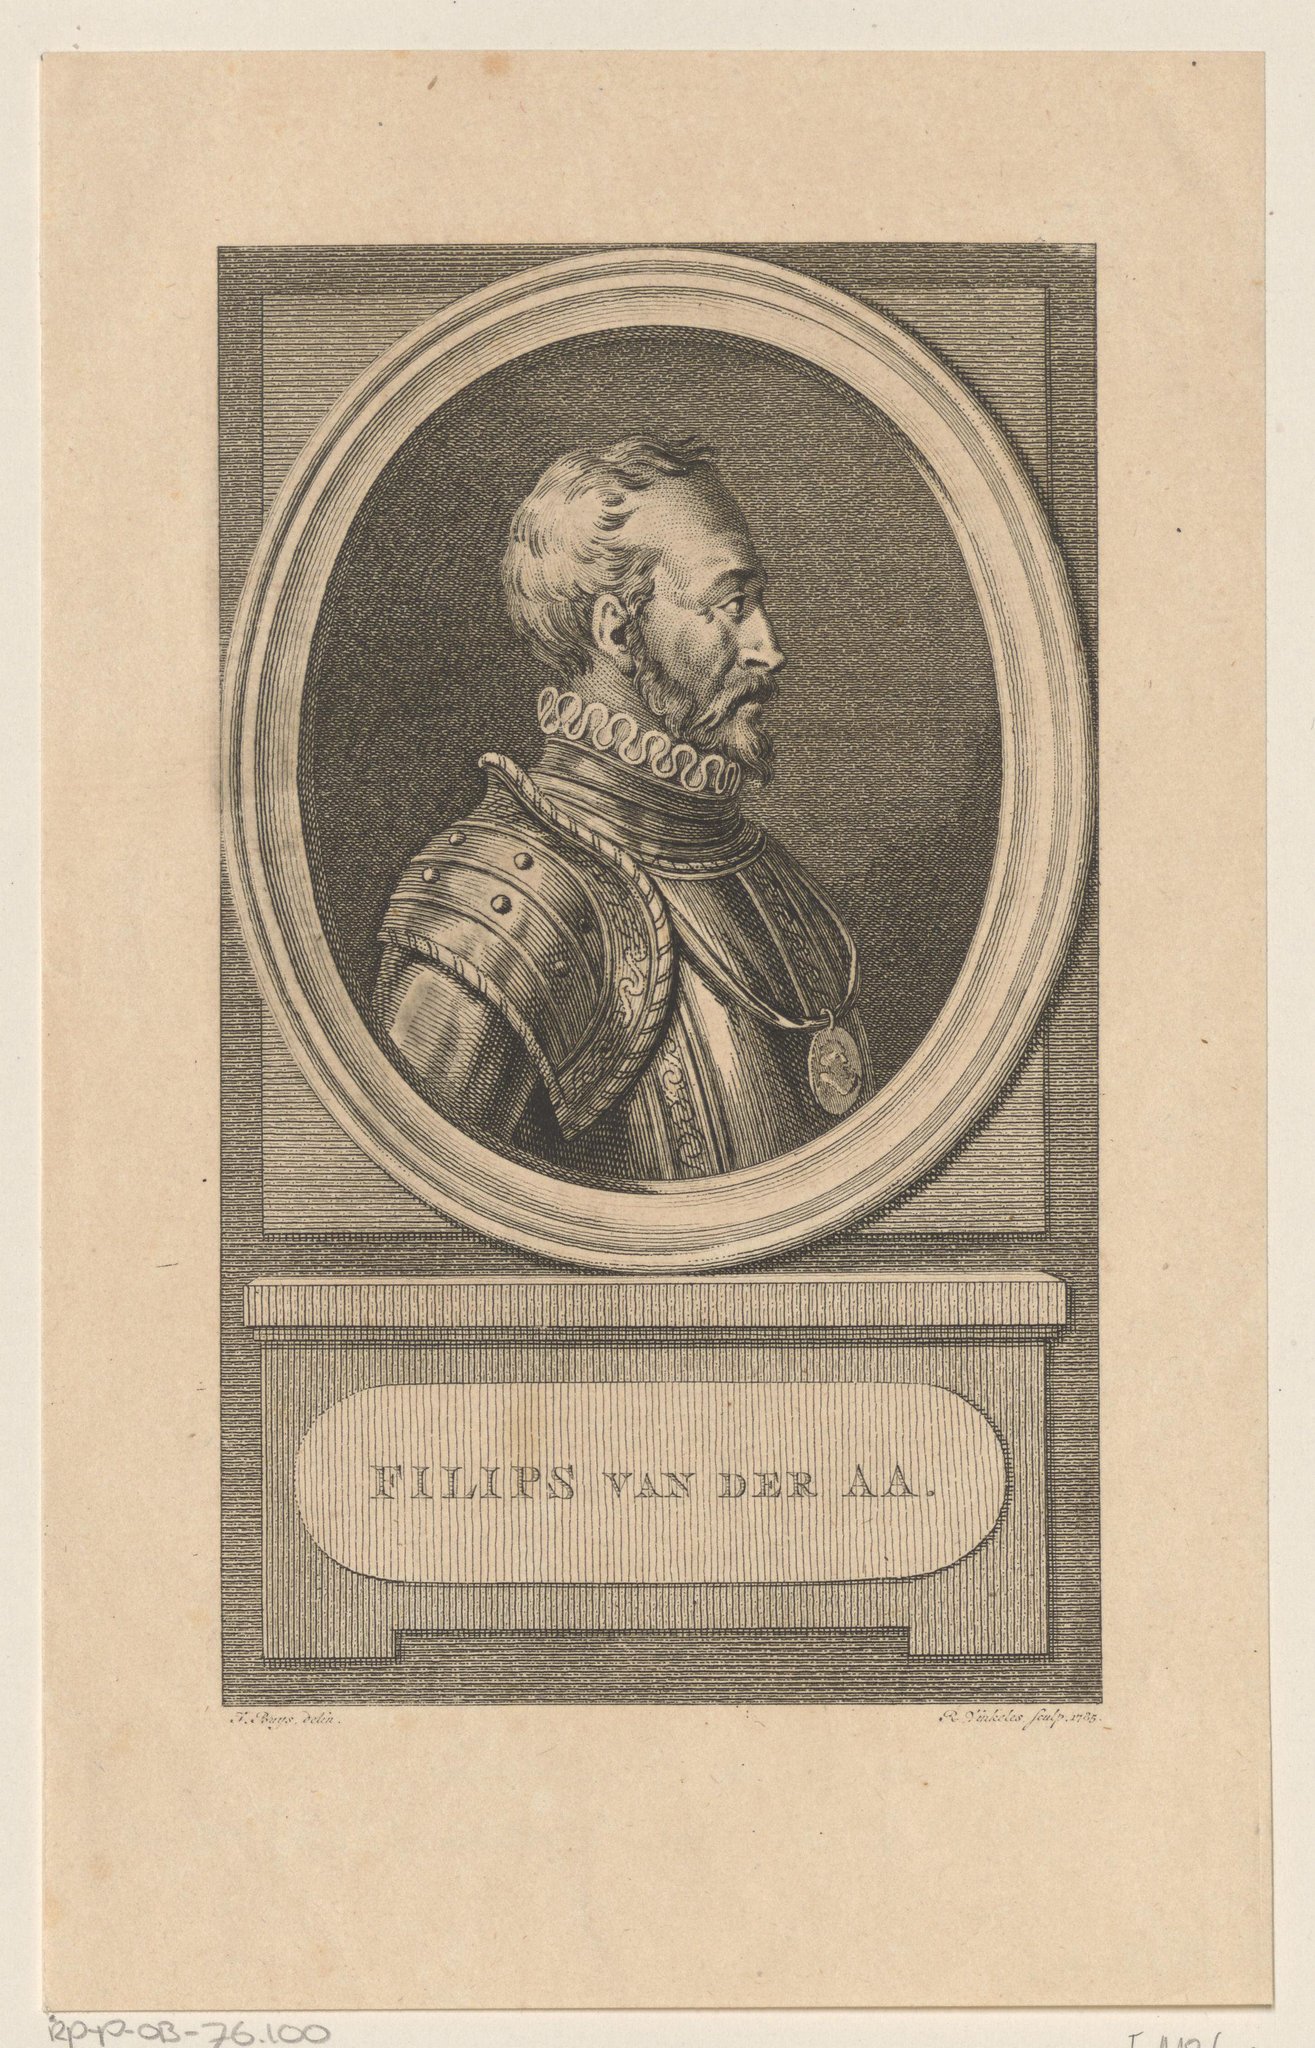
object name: print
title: Portret van Filips van der Aa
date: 1785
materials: paper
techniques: engraving, etching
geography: amsterdam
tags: staatsman, filips van der aa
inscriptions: date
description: Portret van Filips van der Aa in een ovale omlijsting. Daaronder in een kader zijn naam.